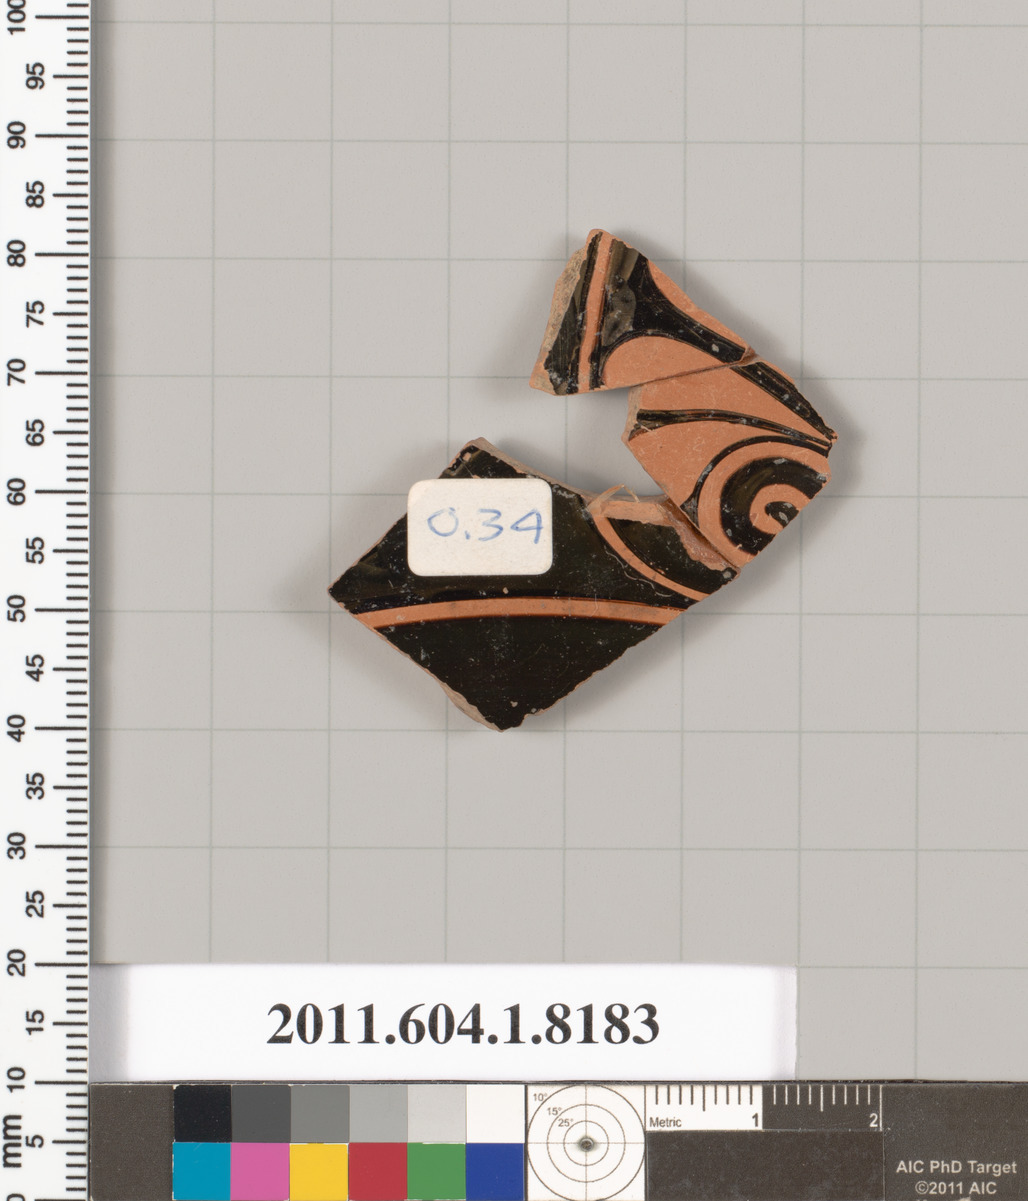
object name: kylix fragment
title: Terracotta fragment of a kylix (drinking cup)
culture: greek, attic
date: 520-510 BCE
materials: terracotta